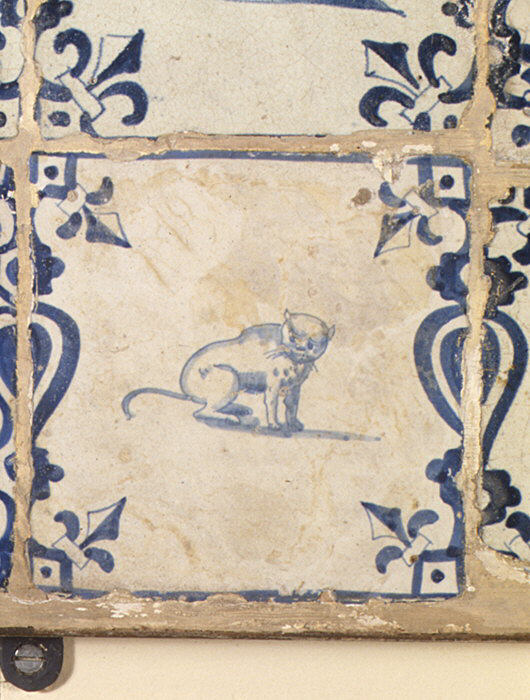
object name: tile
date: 1620-1640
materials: earthenware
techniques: glazing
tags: animals